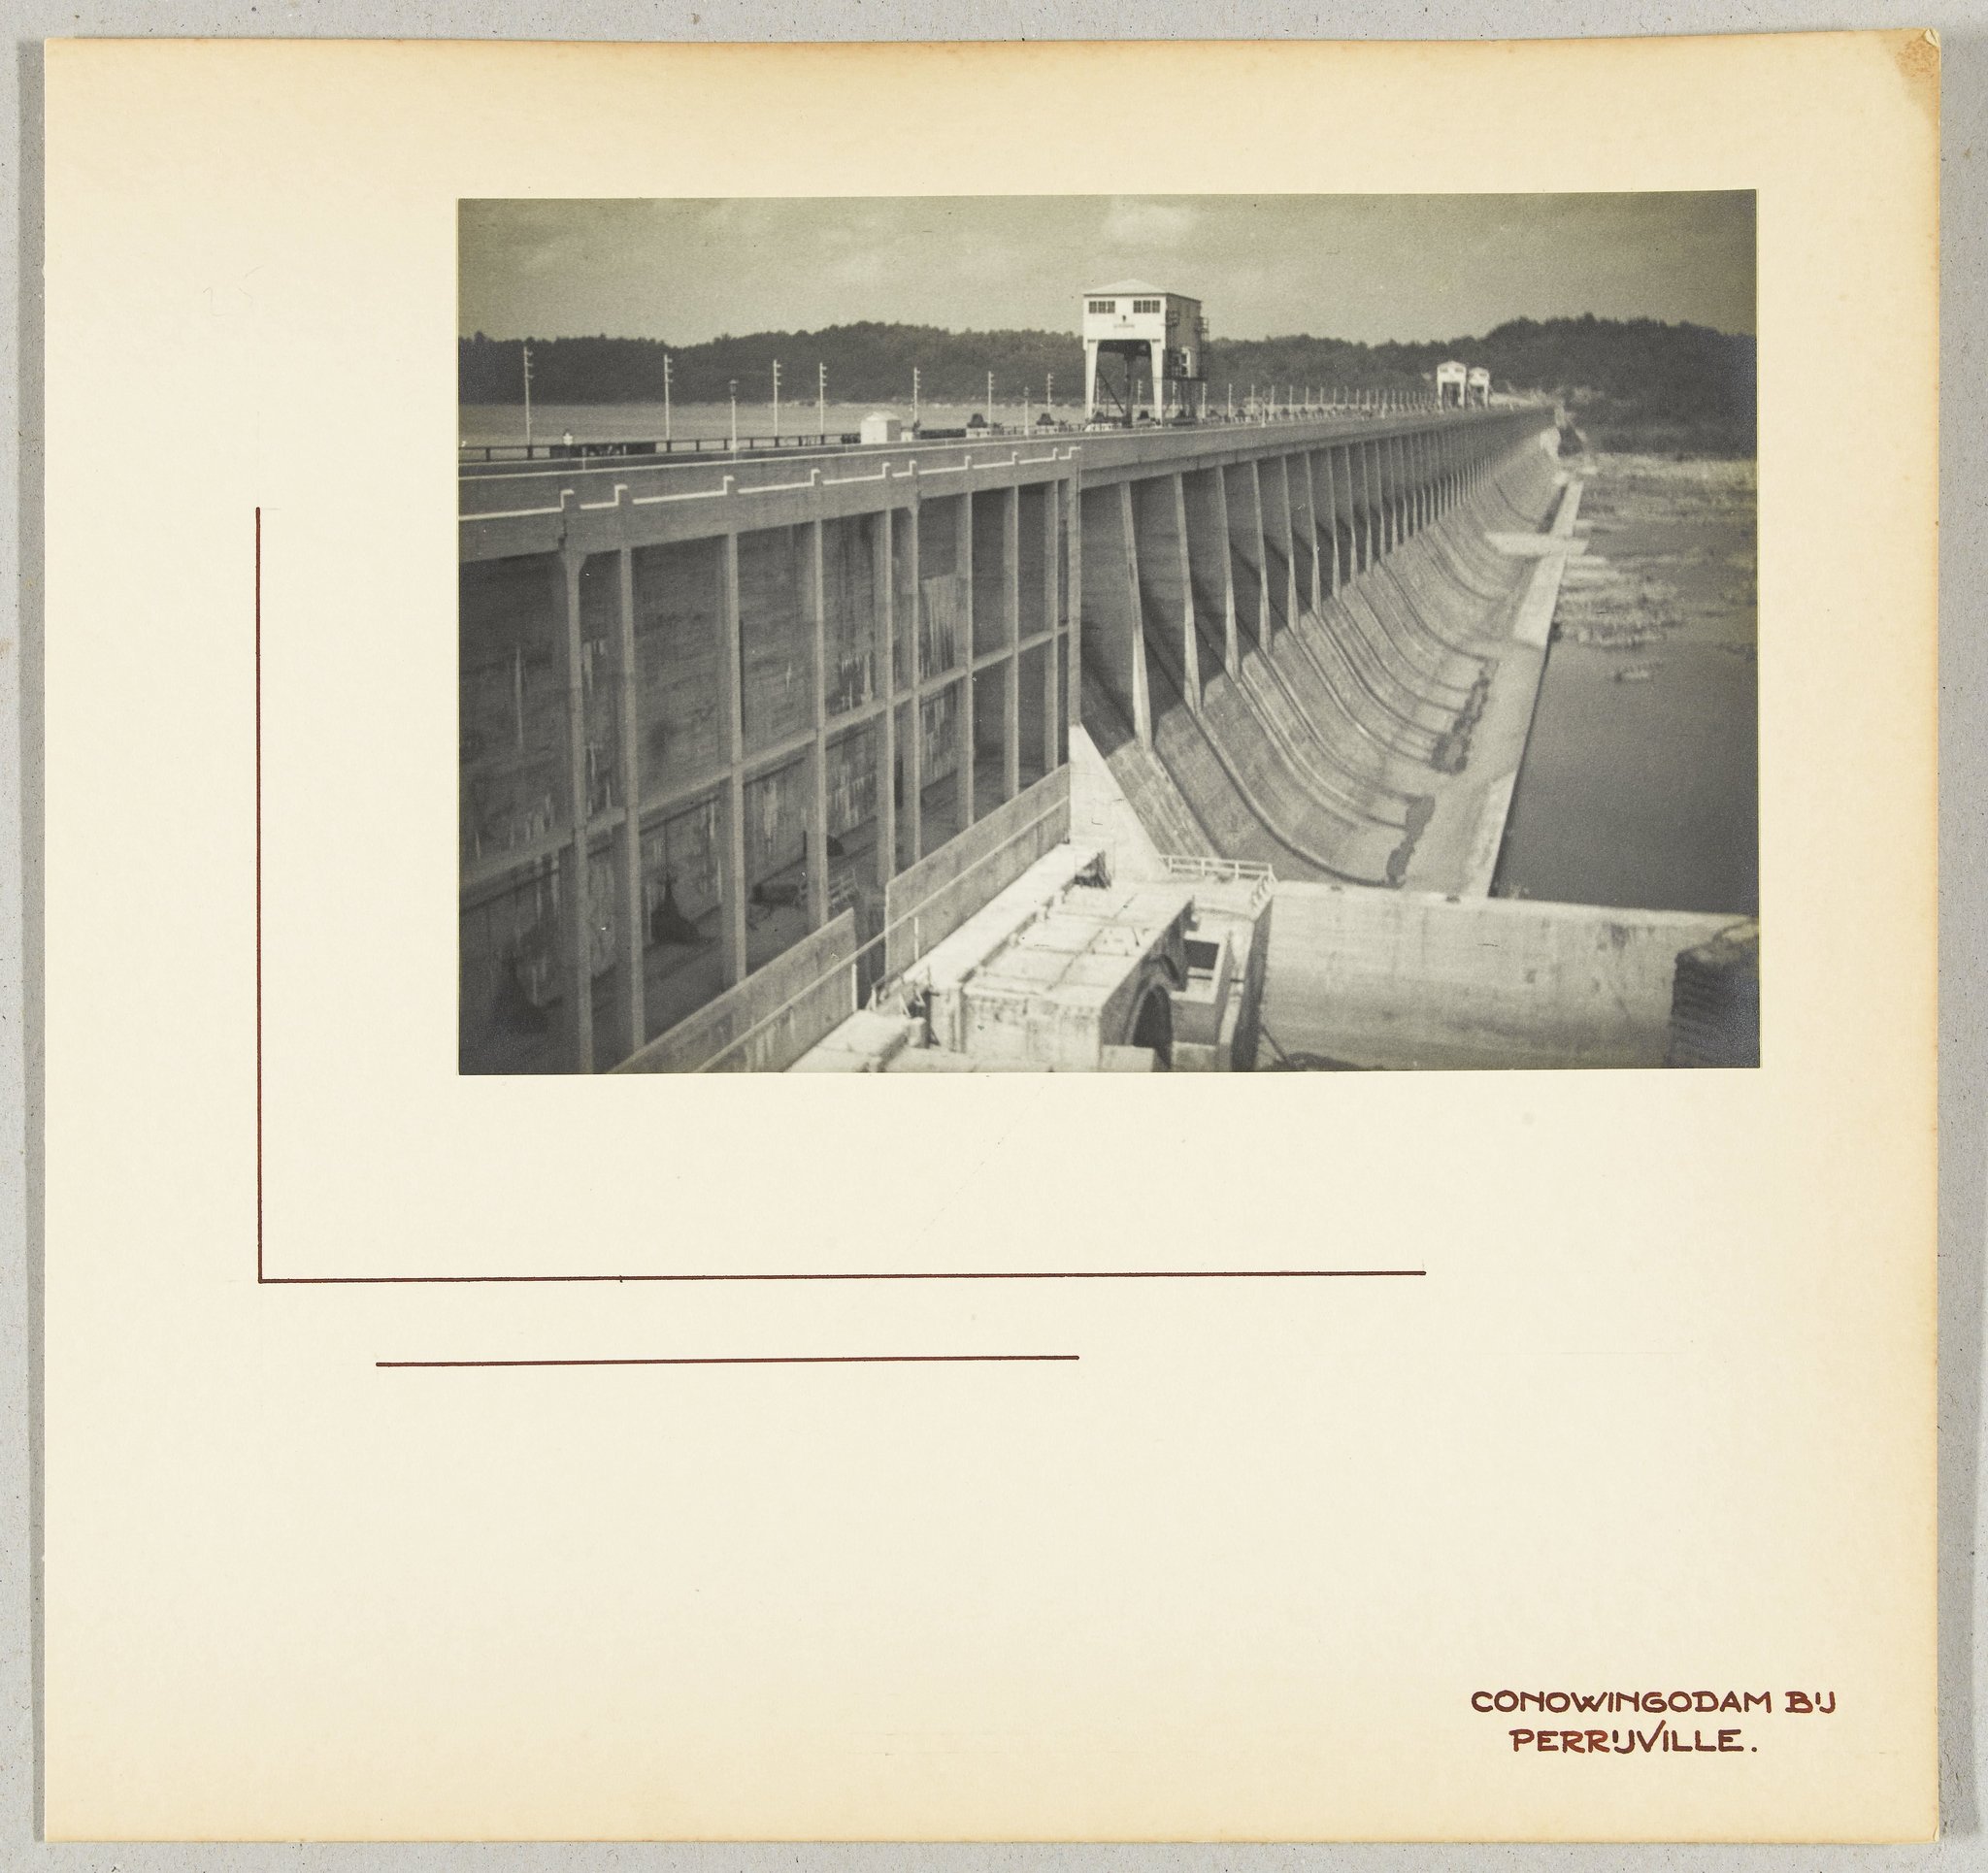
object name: photograph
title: Conowingodam bij Perrijville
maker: wouter cool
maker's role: engineer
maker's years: 1877-1947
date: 1936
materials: cardboard, paper, photographic support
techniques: gelatin silver print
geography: united states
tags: dam (in canal)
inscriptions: title: ‘CONOWINGODAM BIJ / PERRIJVILLE.’